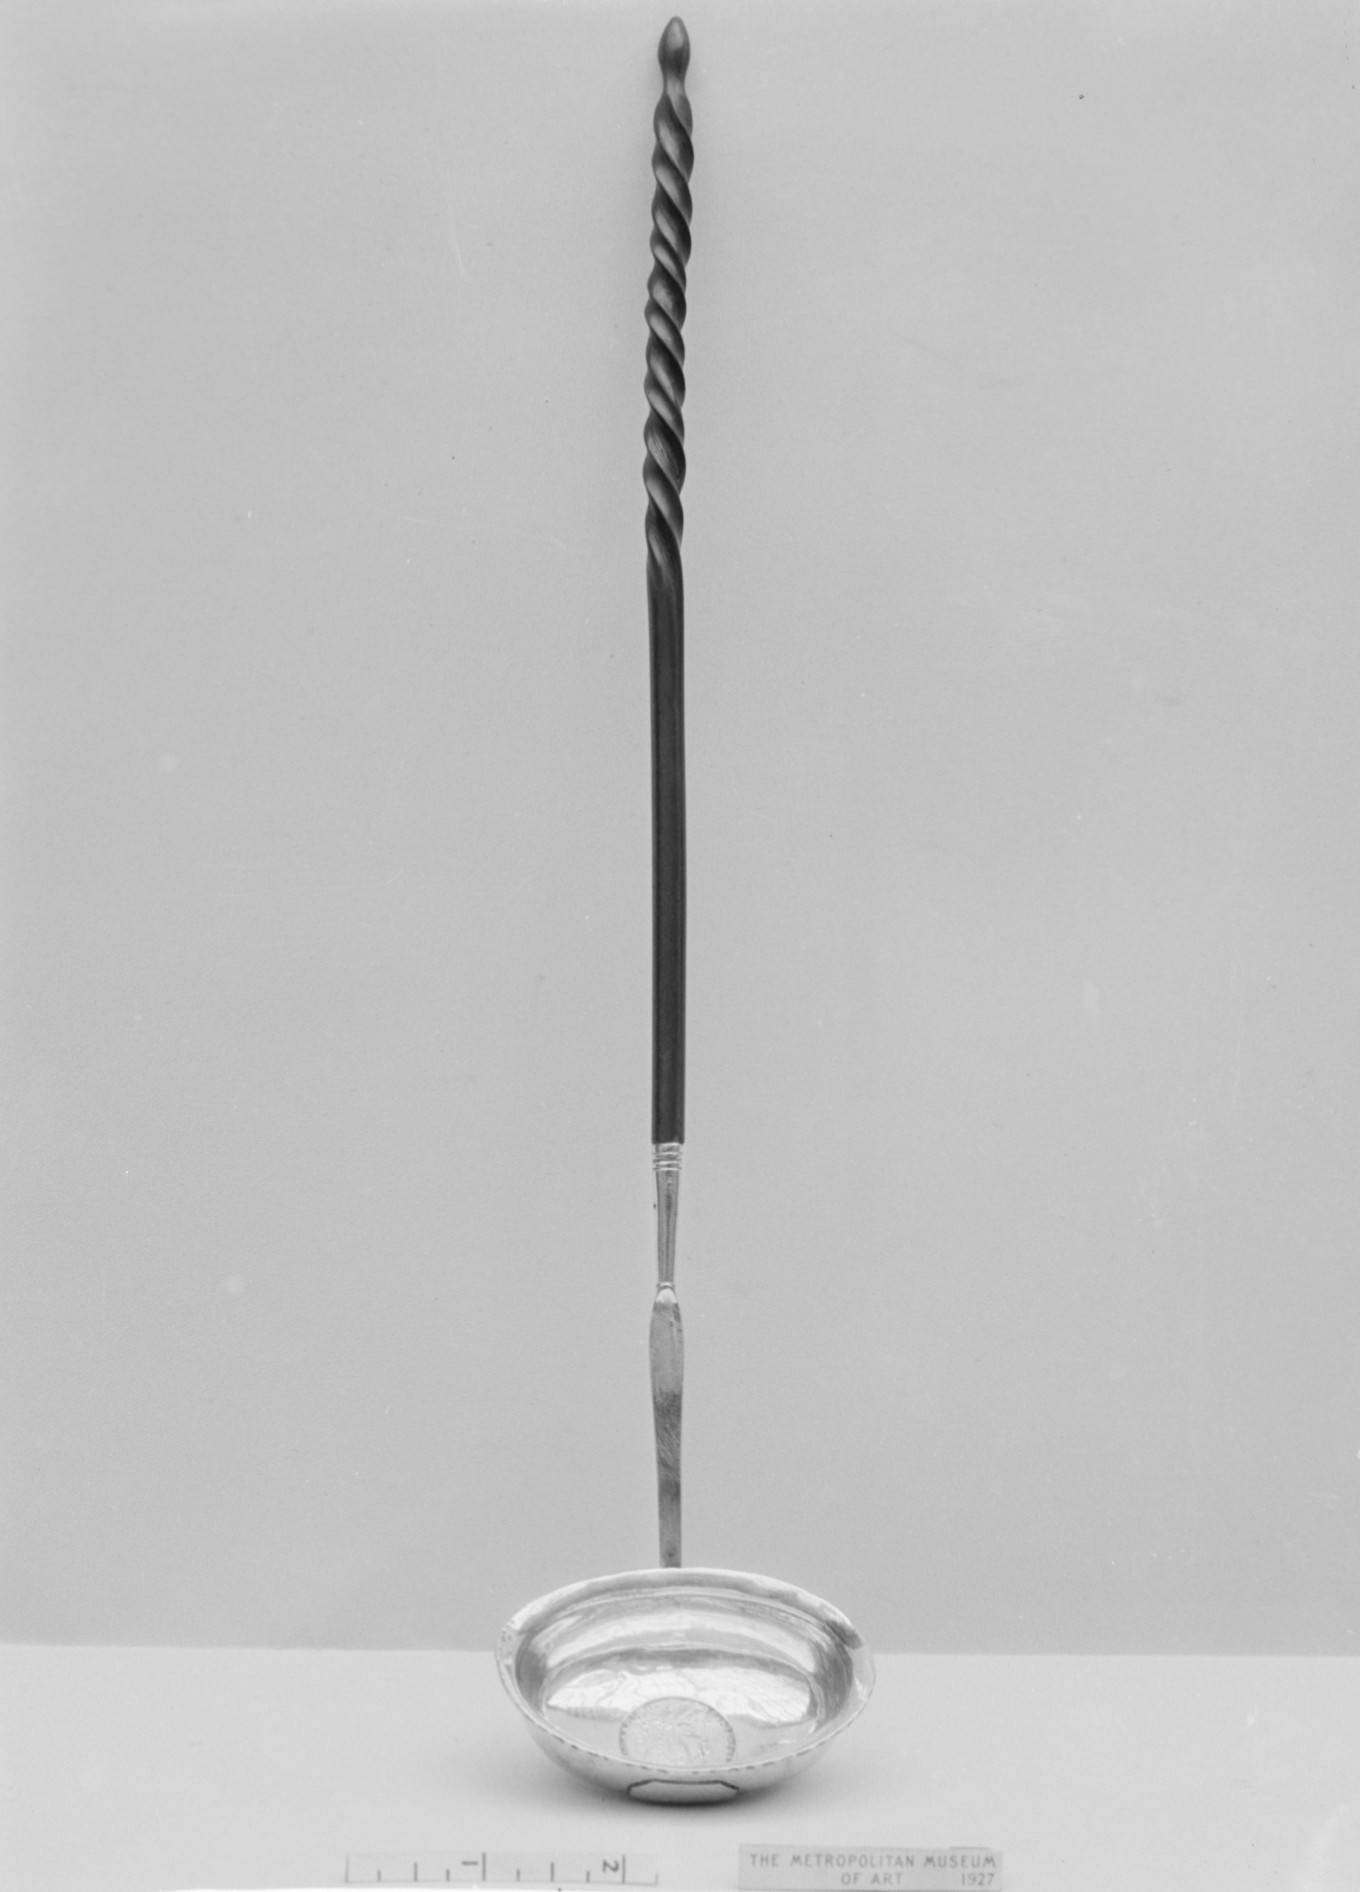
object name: ladle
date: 1780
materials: horn, silver